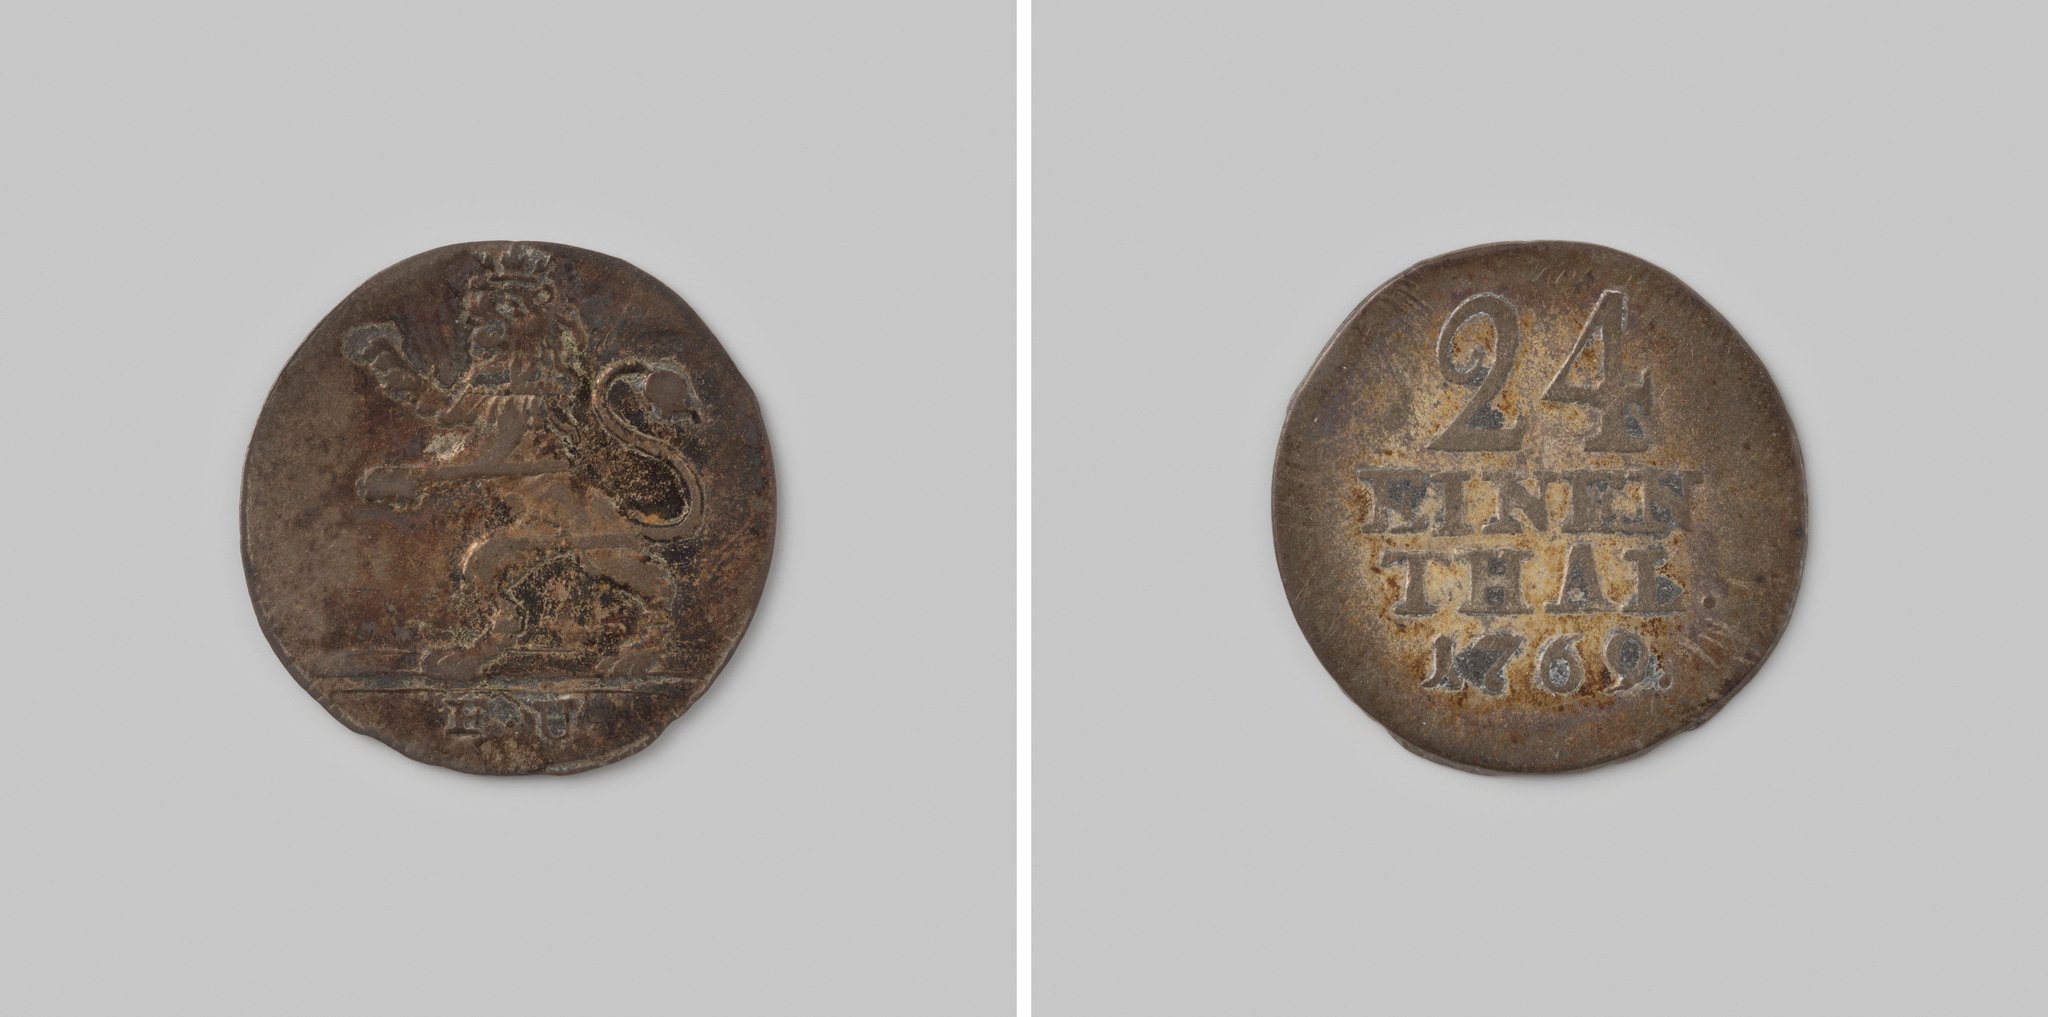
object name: coin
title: Hessen-Kassel, Friedrich II, 1/24 taler, 1769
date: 1769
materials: silver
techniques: striking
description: Zilveren munt. Voorzijde: gekroonde in mantel gehulde klimmende leeuw naar links. Keerzijde: waarde-aanduiding in drie regels, waaronder jaartal. Gladde rand.